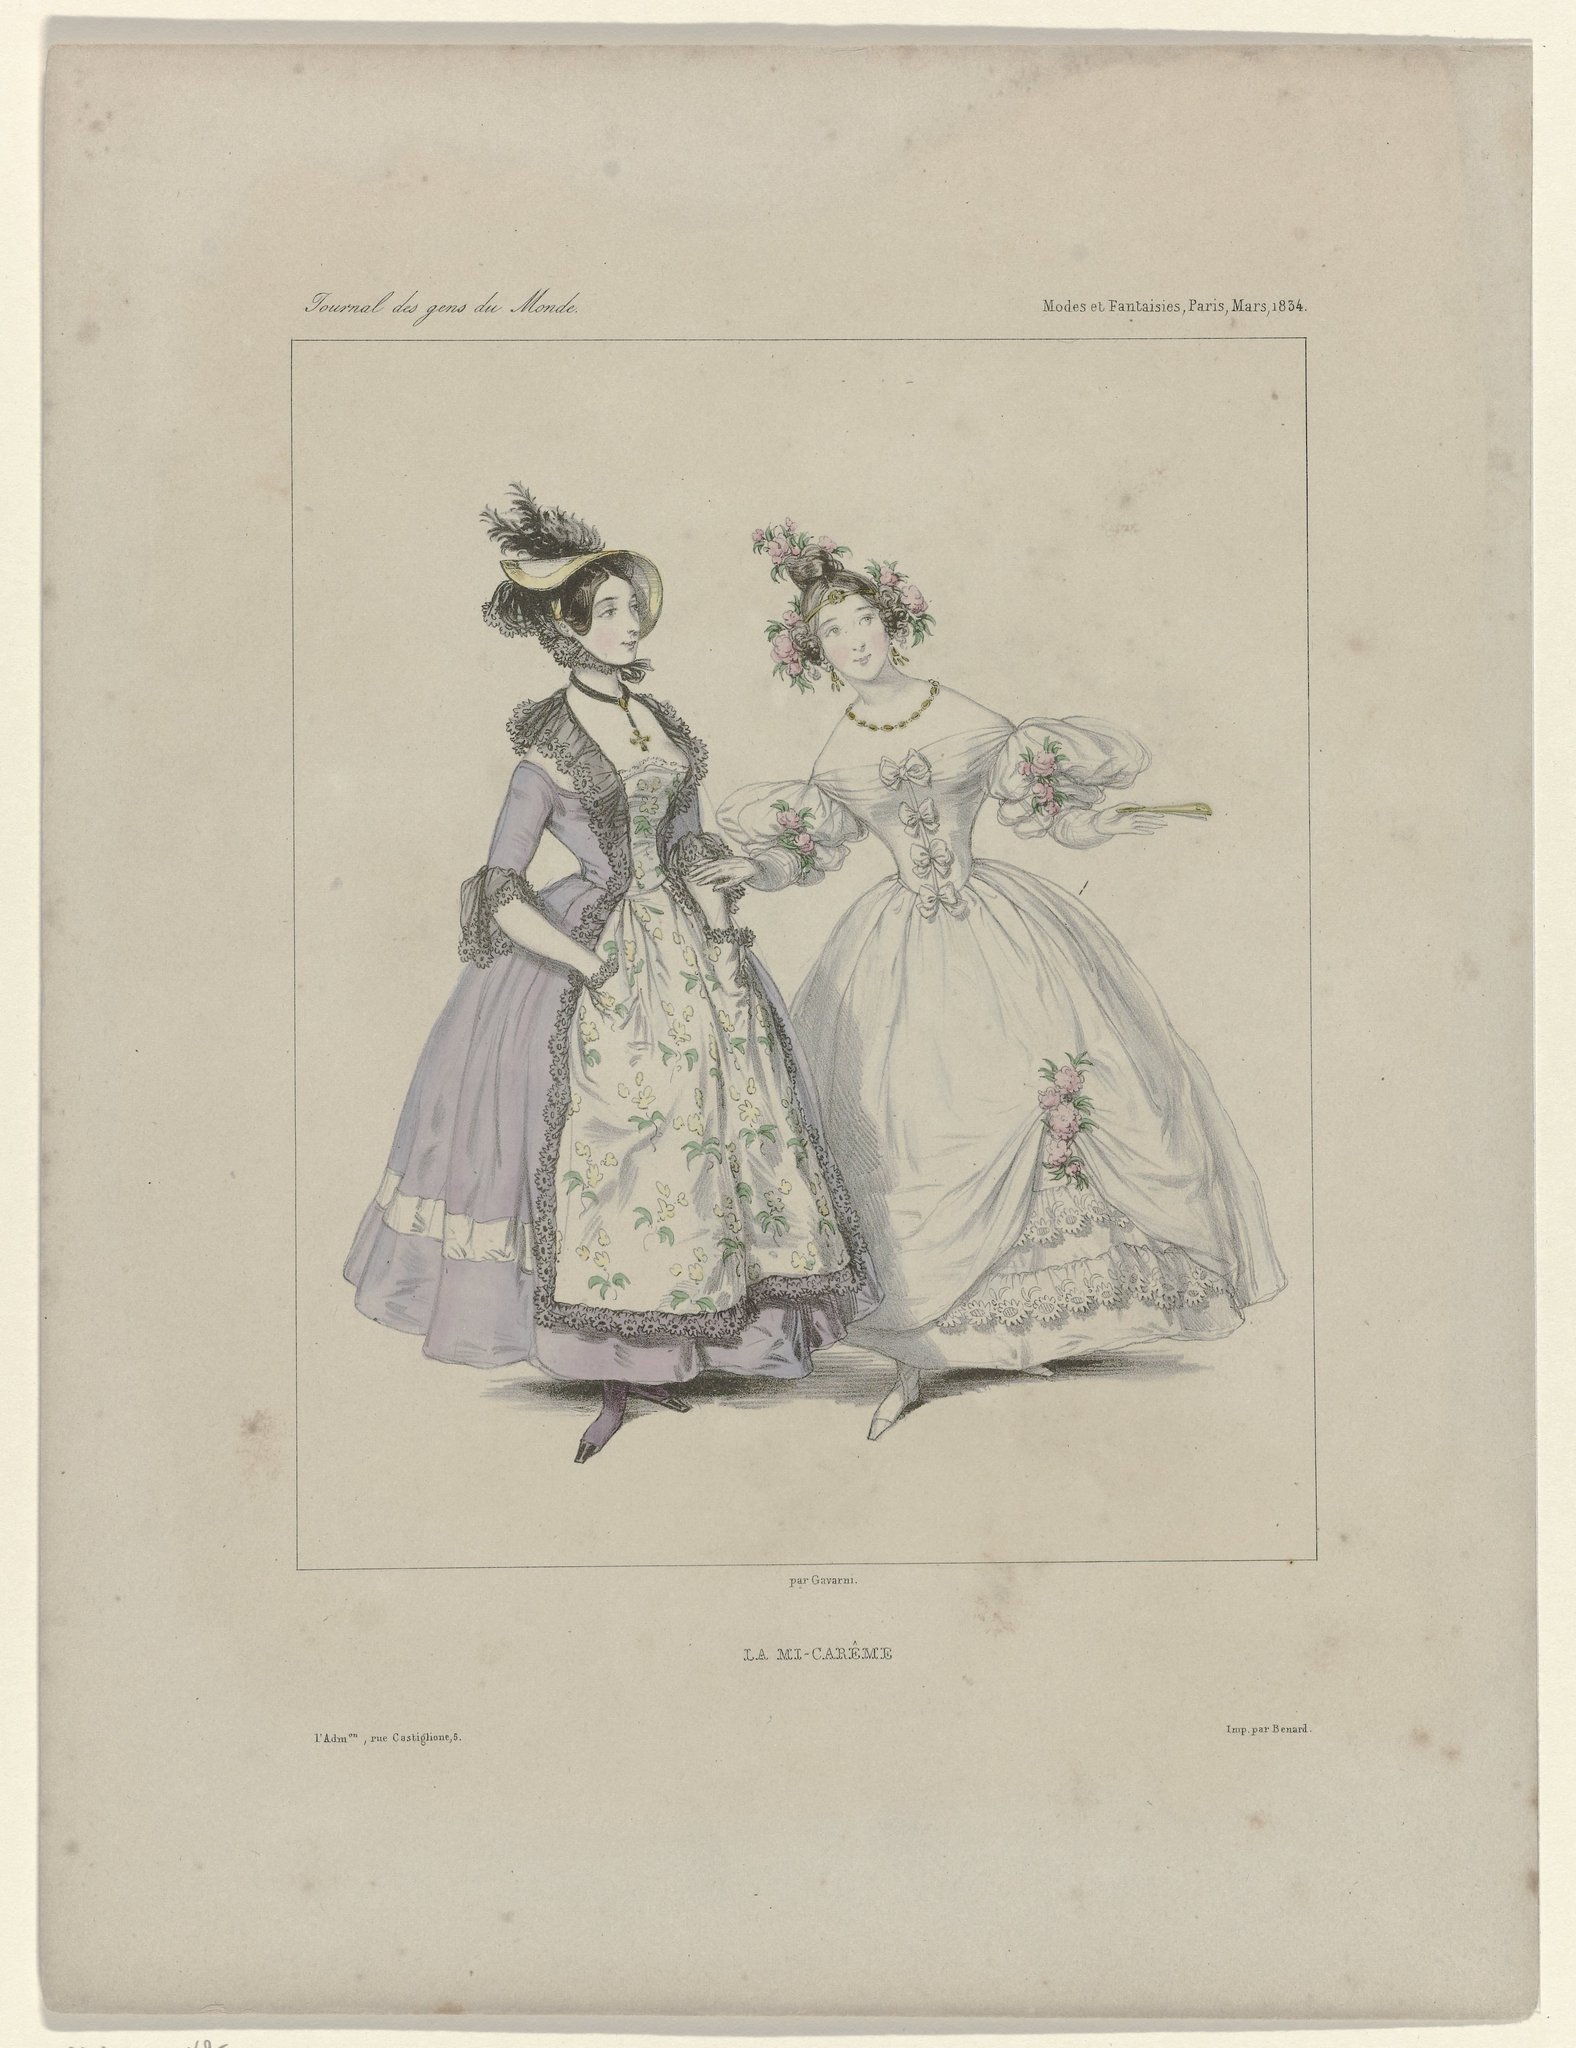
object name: fashion print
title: Journal des Gens du Monde, Modes et Fantaisies, Mars 1834 : La Mi-Carême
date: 1834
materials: paper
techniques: hand coloring, lithograph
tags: corsage (+ women's clothes), flowers, diadem, tiara (+ women's clothes), dress, gown: evening dress (+ women's clothes), party clothes, festive attire (+ women's clothes), fashion plates, head-gear: hat (+ women's clothes), apron (+ women's clothes), necklace (+ women's clothes)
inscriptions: title: ‘Journal des gens du Monde. / Modes et Fantaisies, Paris, Mars, 1834’, caption: ‘LA MI-CARÊME’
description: Twee vrouwen gekleed voor het gekostumeerde bal van mi-caême (halfvasten) Links: vrouw in japon en sierschort met bloemmotief, afgezet met gerimpelde strook kant(?). Platte hoed met voile en veren. Collier met hanger in de vorm van een kruis. Rechts: vrouw in avondjapon met boothals. Lijfje versierd met rij strikken. Korte pofmouwen met drie lagen. Bloemcorsages op mouwen en rok. Wijde rok aan voorzijde opgehouden, onderrok met gerimpelde stroken stof. Accessoires: diadeem, oorbellen, collier, waaier. prent uit Journal des Gens du Monde.... Dit luxueus uitgevoerde tijdschrift werd van 6 december 1833 tot mei 1834 uitgegeven, en geleid door Gavarni.